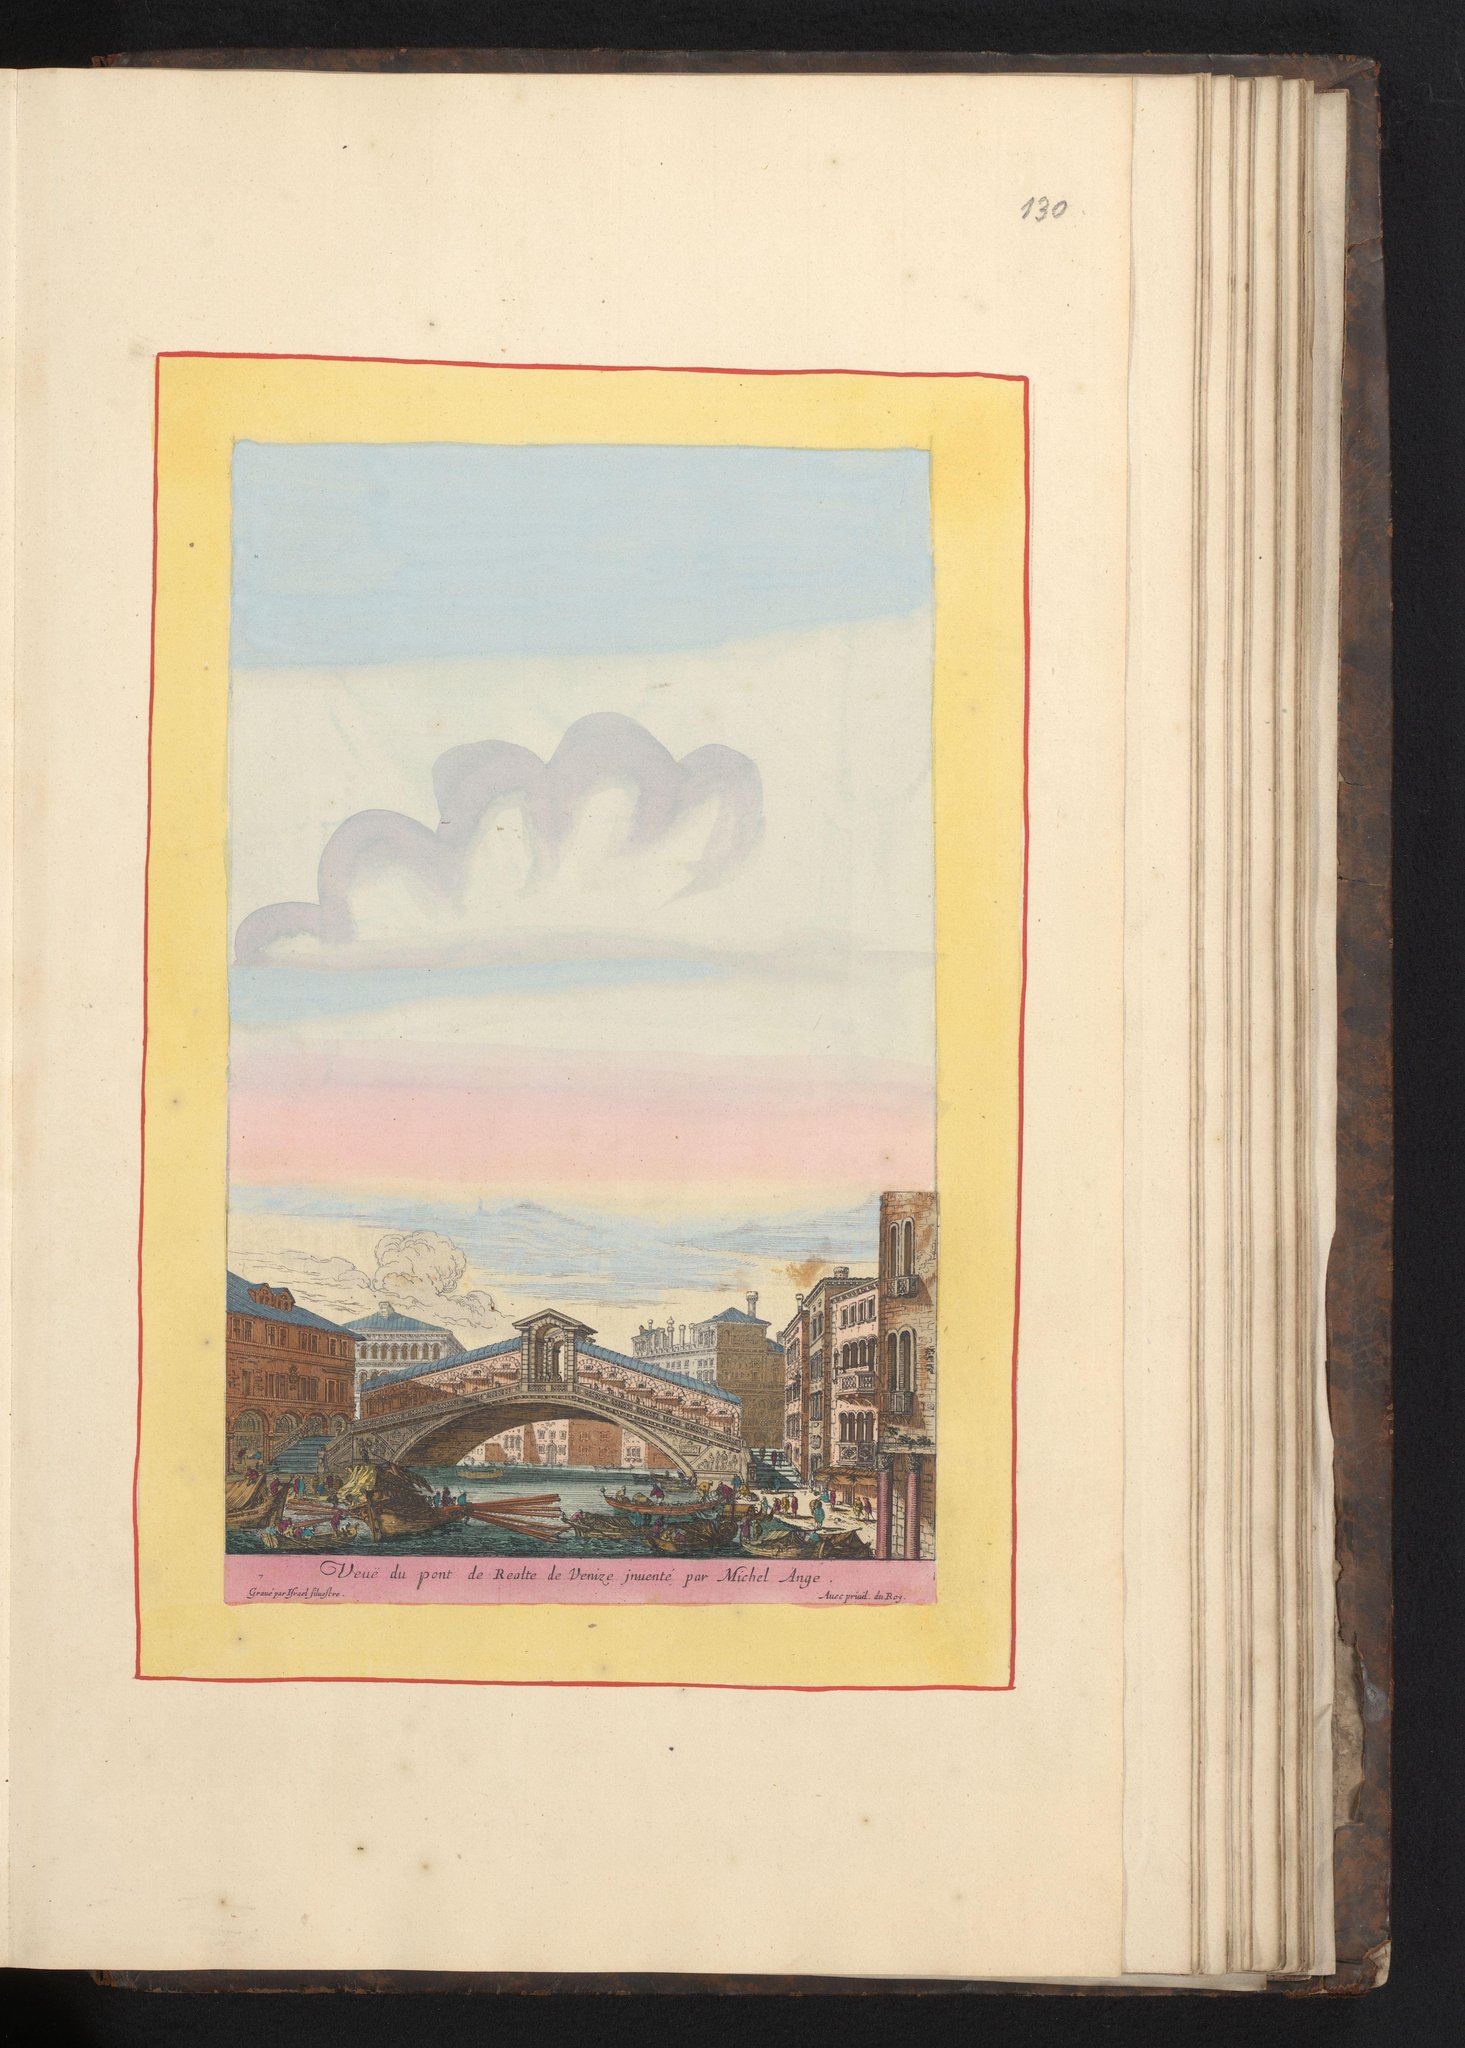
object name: album leaf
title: Rialtobrug te Venetië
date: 1631-1691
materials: paper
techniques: colour, etching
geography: paris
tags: city-view, and landscape with man-made constructions, canal, bridge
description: Prent maakt deel uit van een reeks van 12 prenten met gezichten op plekken in Italië. De prent is langs de bovenrand van de voorstelling afgescheurd. De voorstelling is aan de bovenzijde aangevuld met een geschilderde lucht.